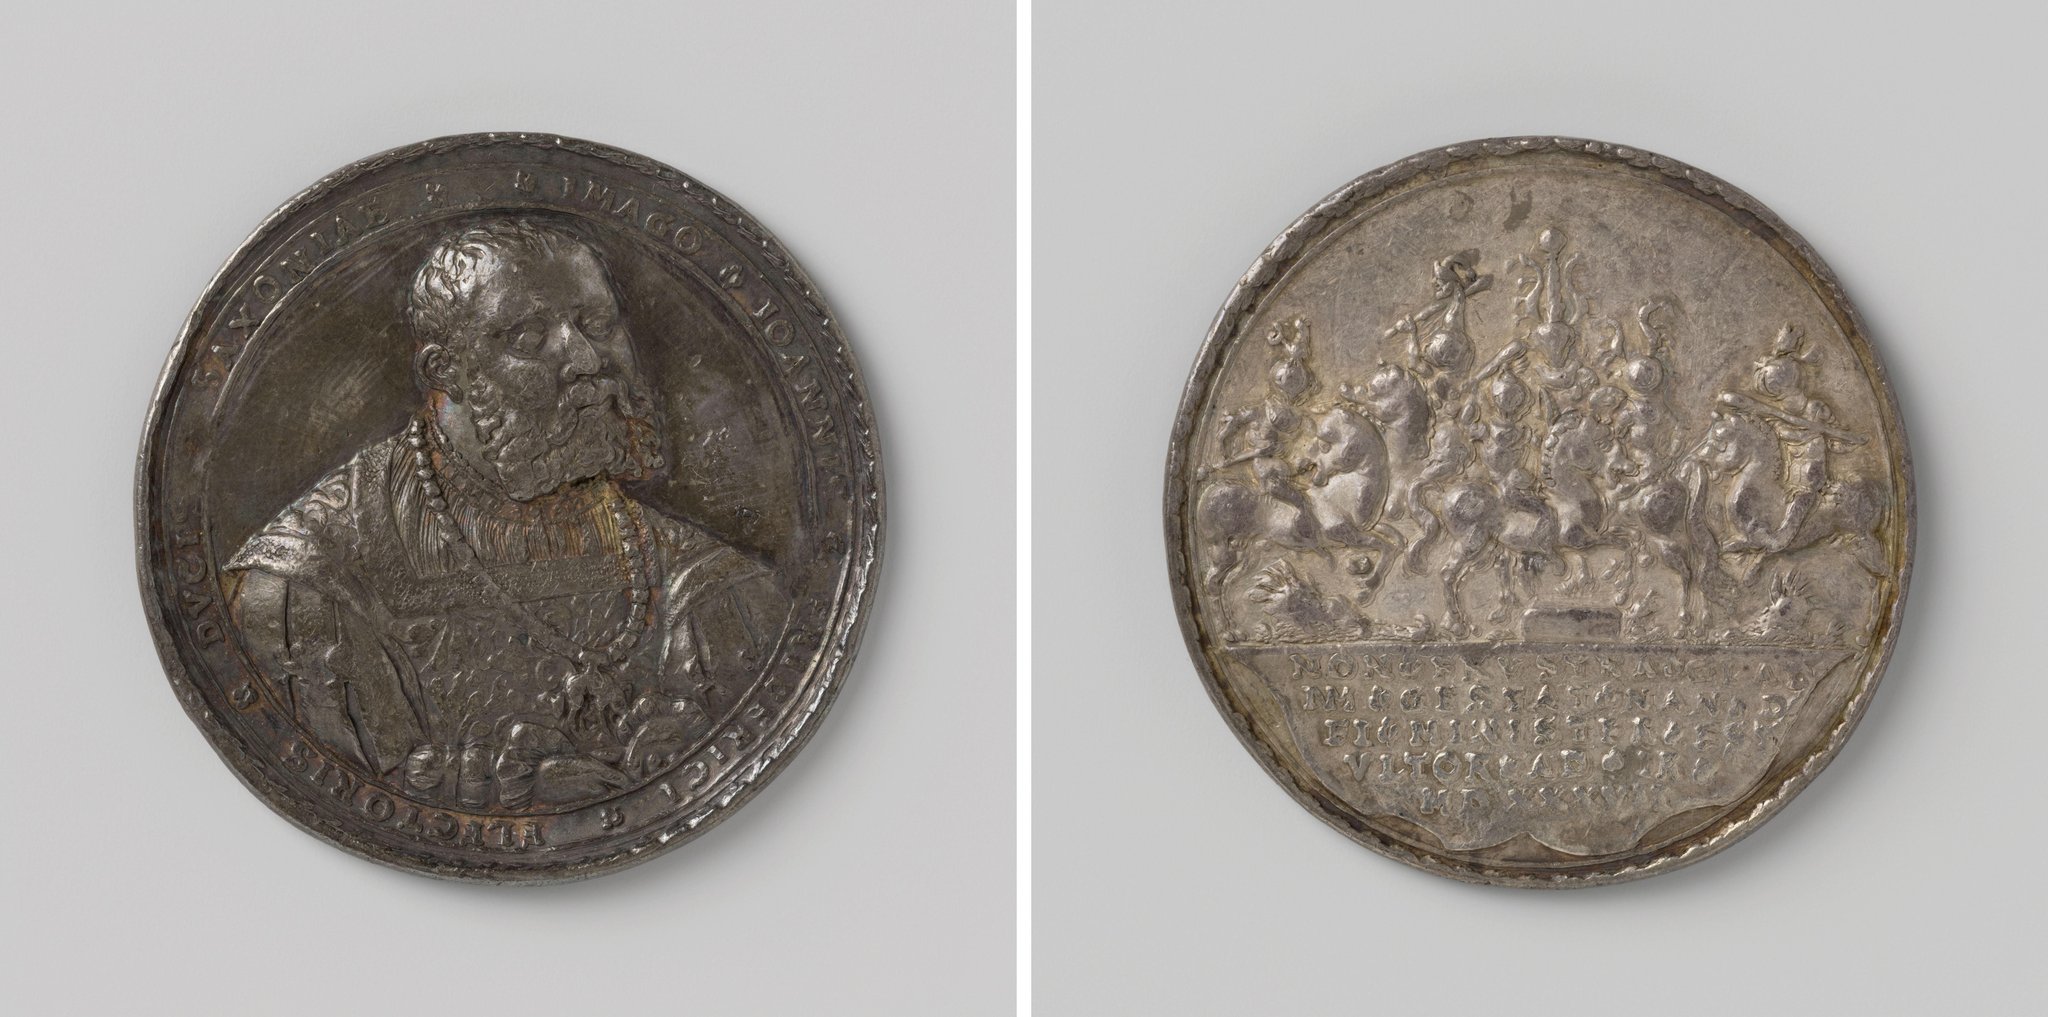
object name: history medal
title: Johan Frederik de Grootmoedige, keurvorst van Saksen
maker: Anonymous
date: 1537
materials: silver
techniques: casting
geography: germany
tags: torgau, weimar, keurvorst, johan frederik i (keurvorst van saksen)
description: Zilveren penning. Voorzijde: borststuk man binnen omschrift. Keerzijde: zes ruiters met saksische helmen binnen bladerkrans; afsnede: opschrift binnen bladerkrans